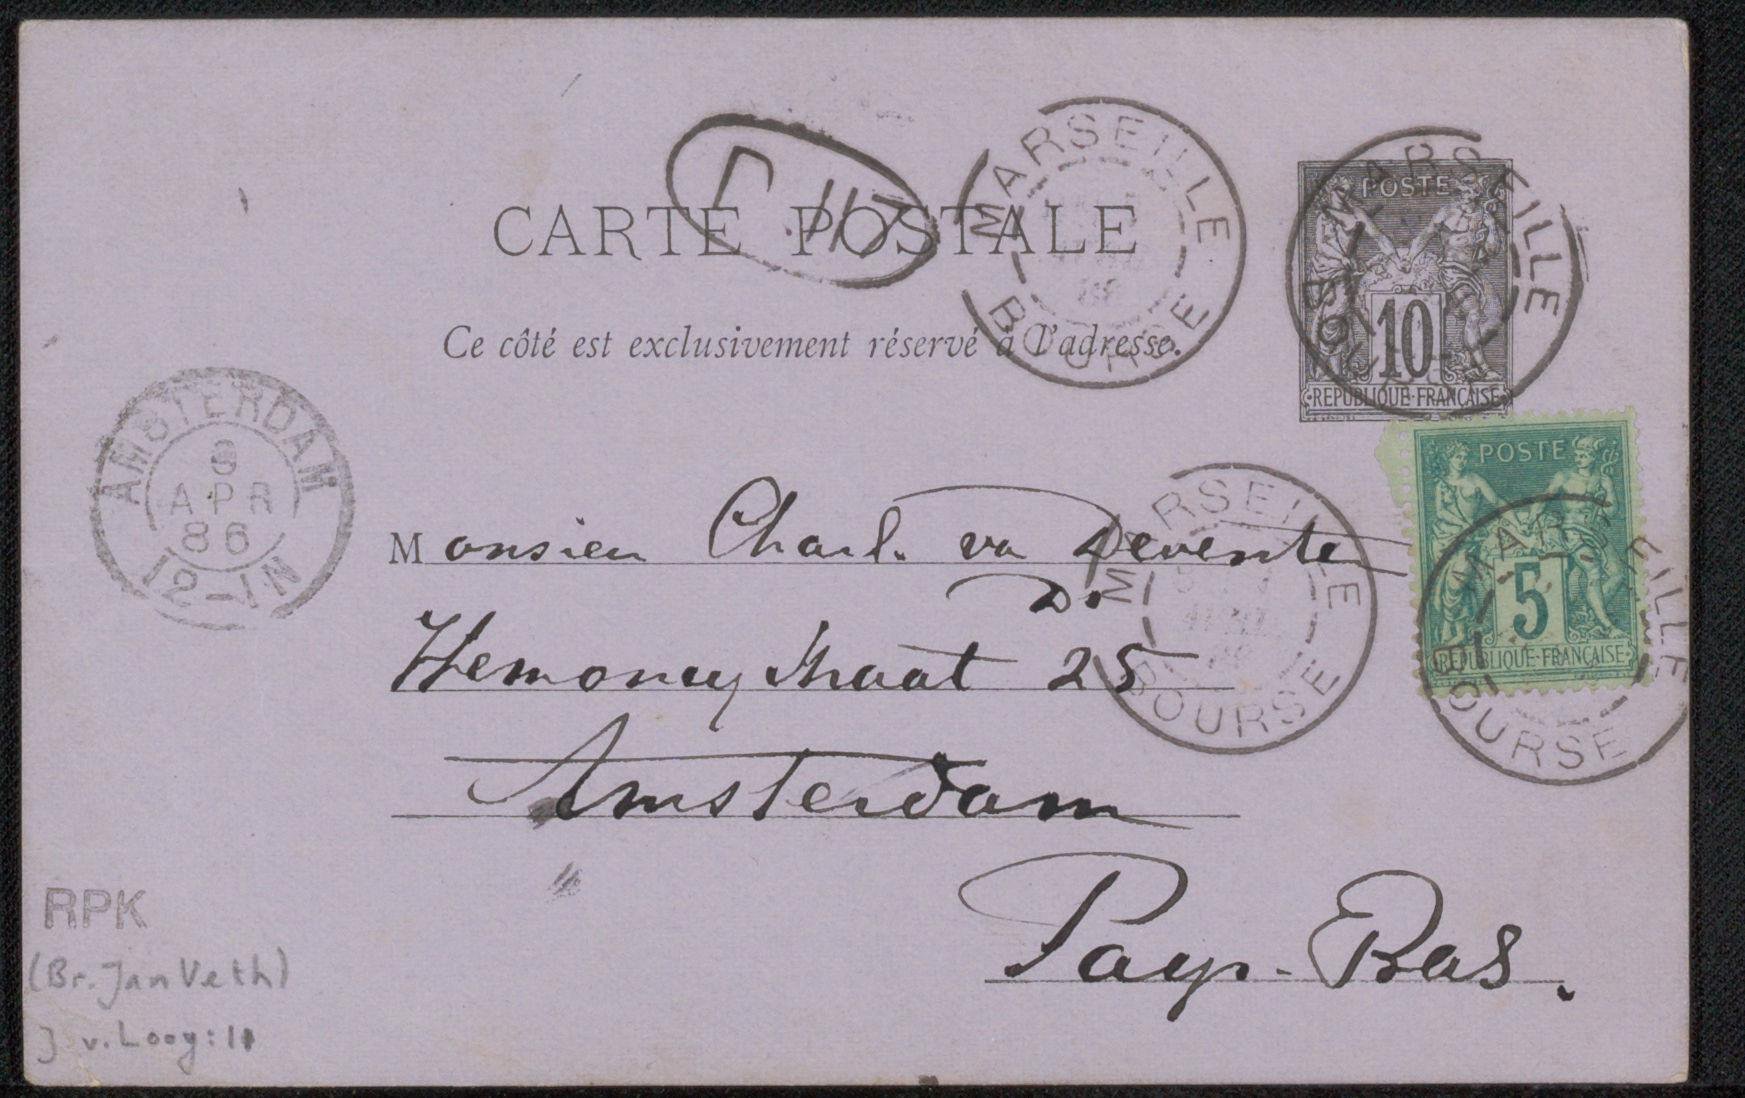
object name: postcard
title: Briefkaart aan Chap van Deventer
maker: jac van looij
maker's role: draughtsman, painter, print maker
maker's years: 1855-1930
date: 1886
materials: cardboard, ink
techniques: pen, writing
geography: marseille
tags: dordrecht, amsterdam, chap van deventer, paris, emile zola, historical persons (portraits and scenes from the life), italy, france, marseille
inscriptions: collector's mark: ‘RPK’